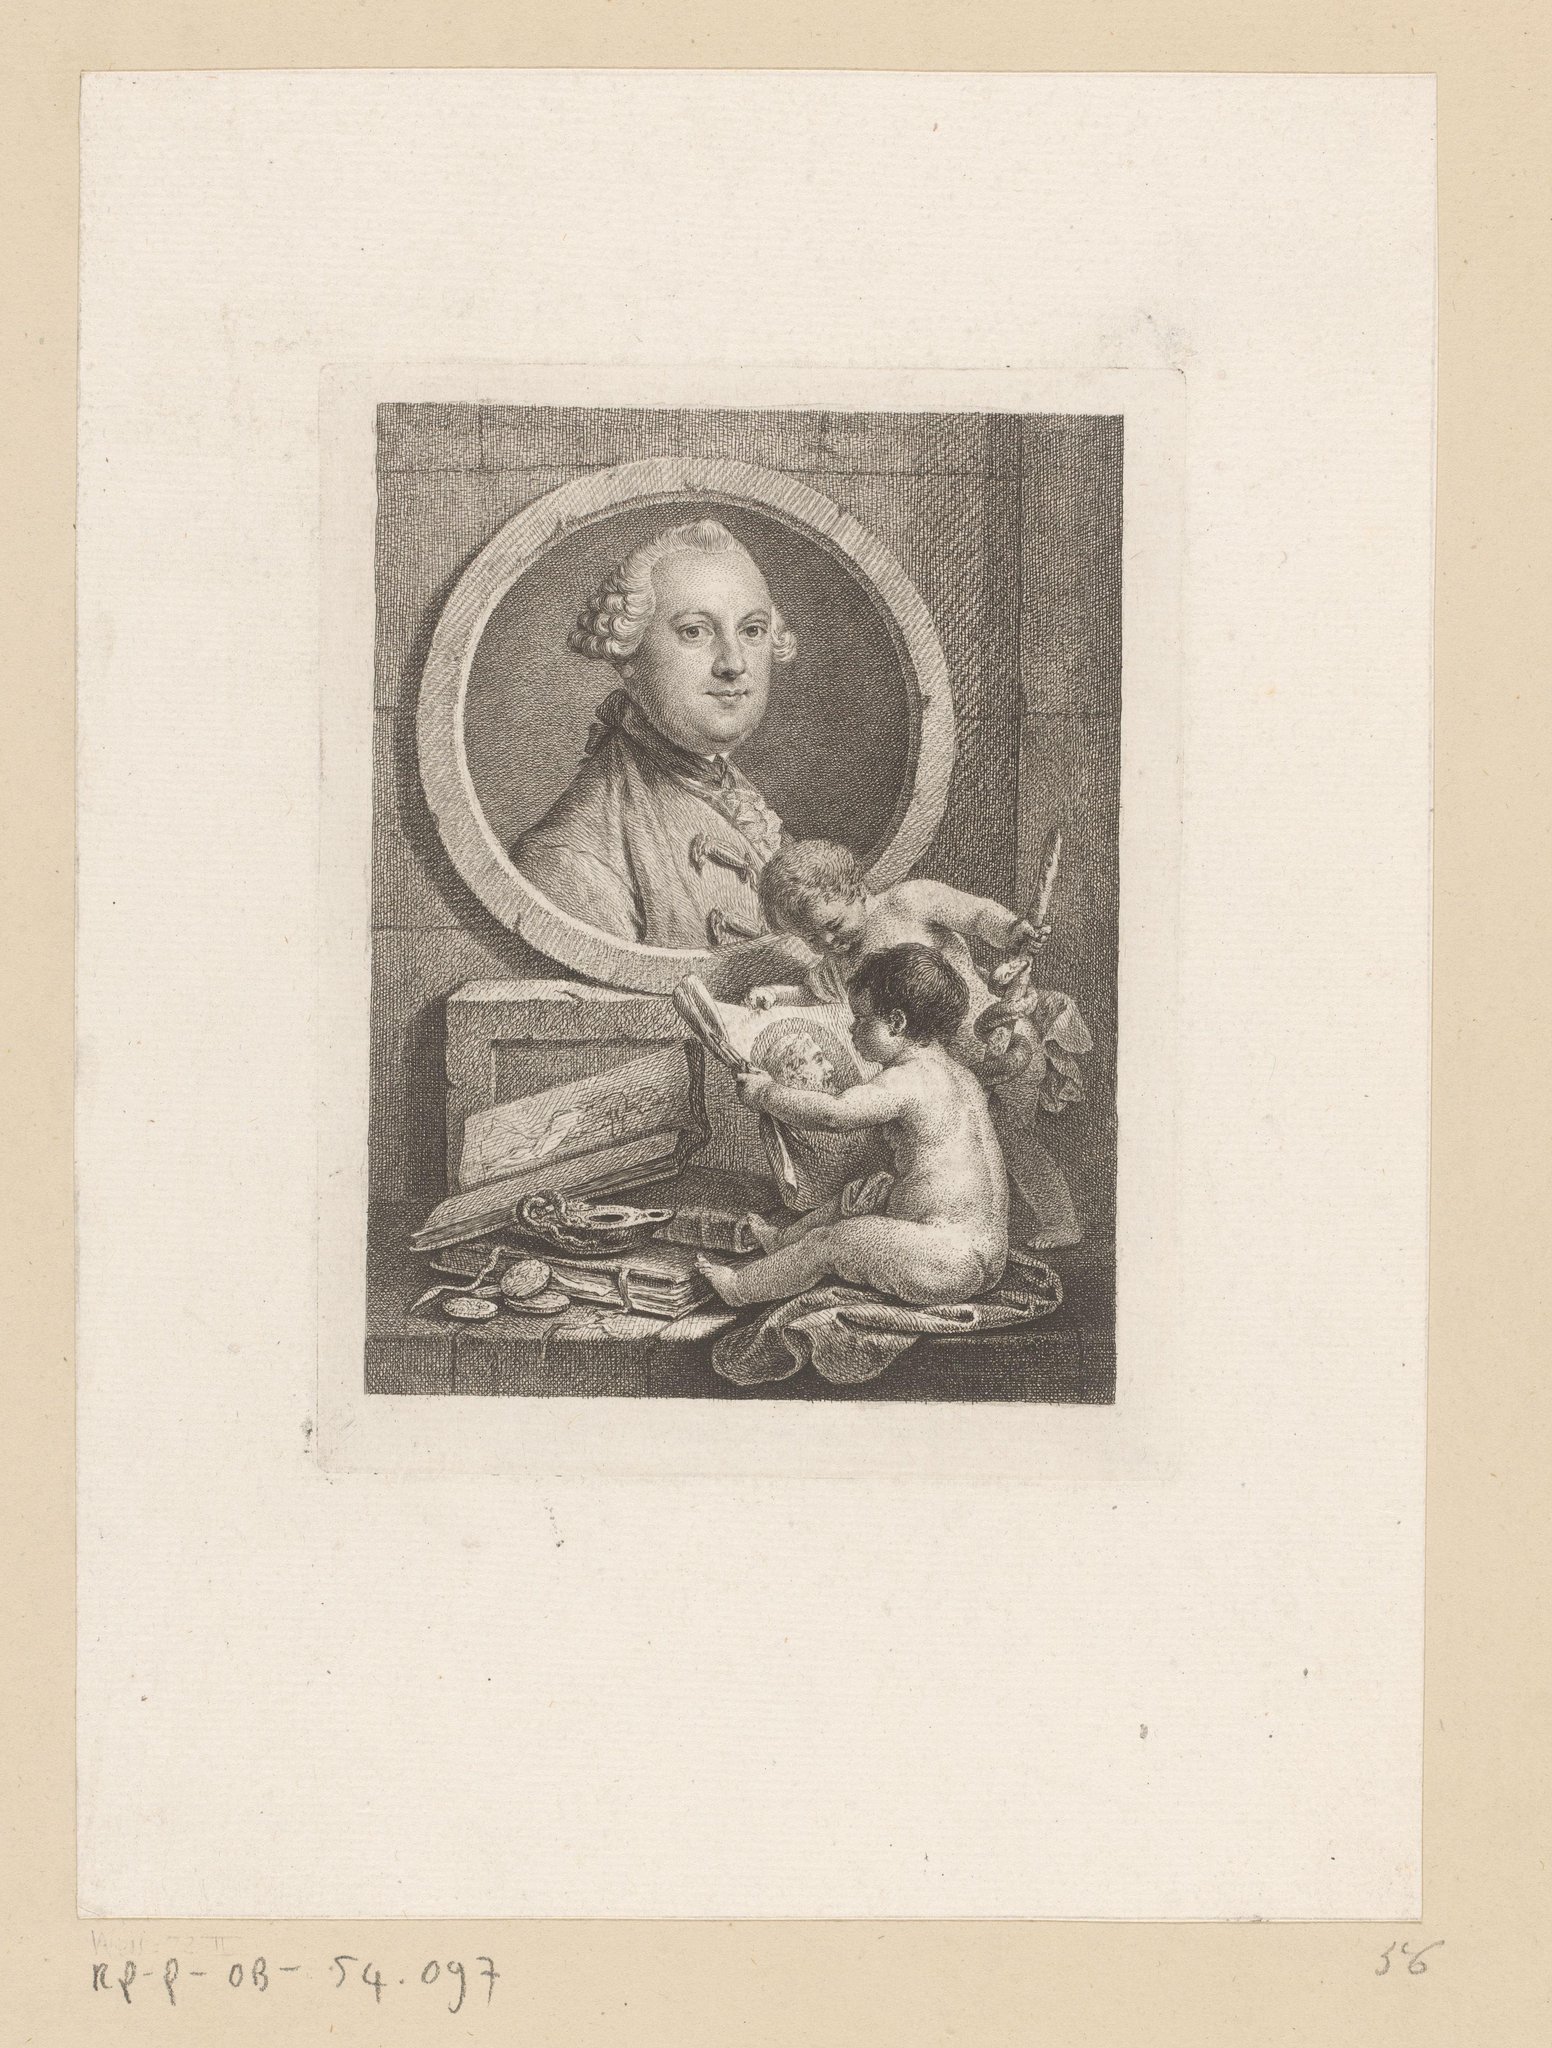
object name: print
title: Portret van Johann Carl Wilhelm Moehsen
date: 1771-1775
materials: paper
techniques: etching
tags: historical persons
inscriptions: collector's mark: Lugt 240